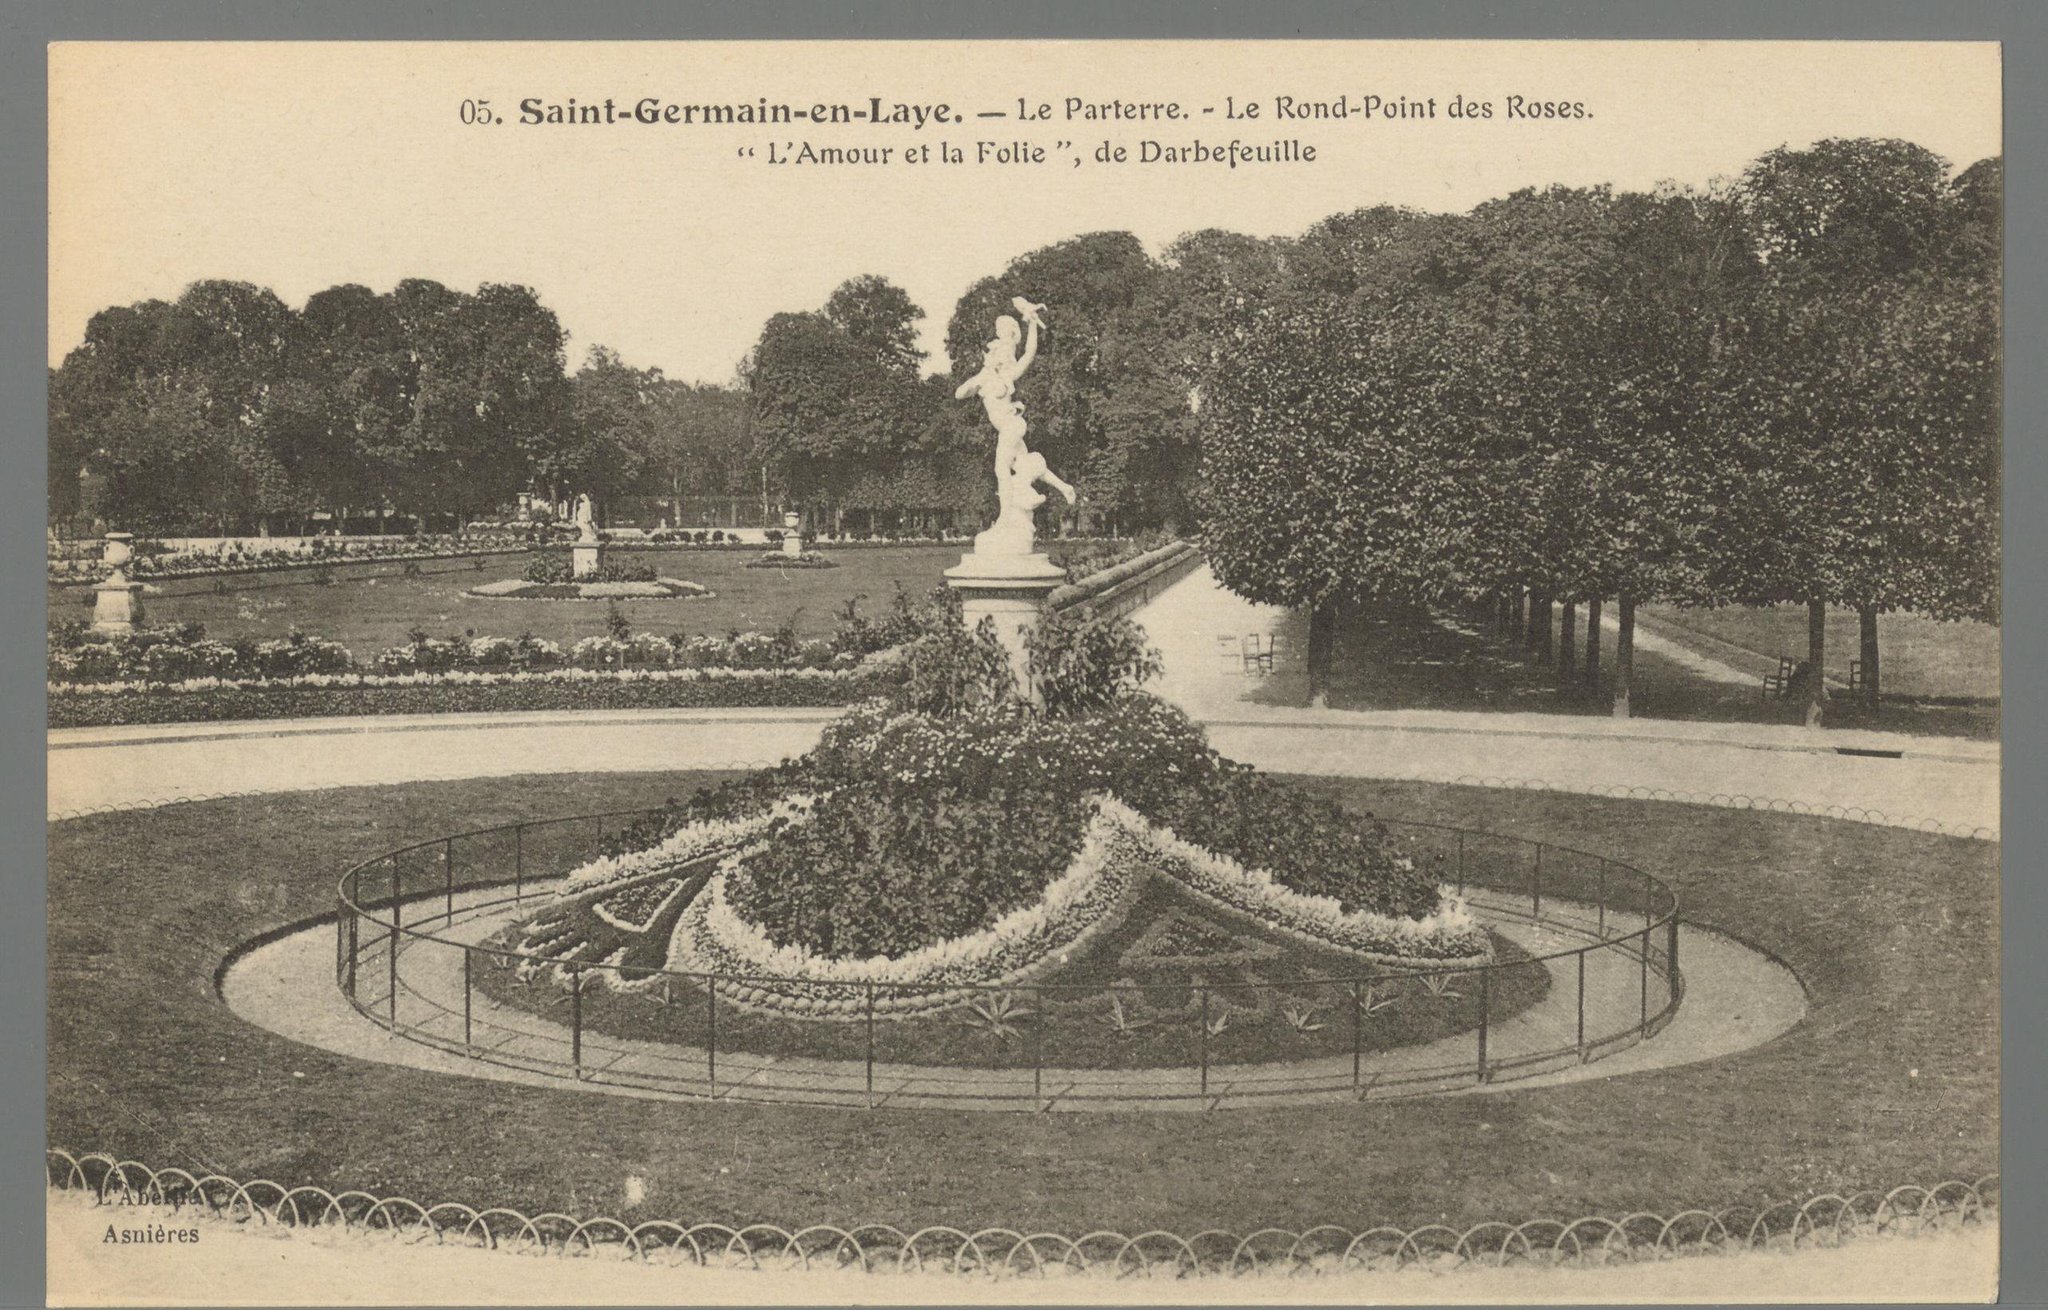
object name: ansichtkaart, prentbriefkaart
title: Saint-Germain-en-Laye. Le Parterre. Le Rond-Point des Roses. 'L'amour et la Folie', de Darbefeuille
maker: Anonymous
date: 1903-1920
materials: cardboard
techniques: photograph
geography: saint-germain-en-laye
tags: park, statues, sculptures in garden